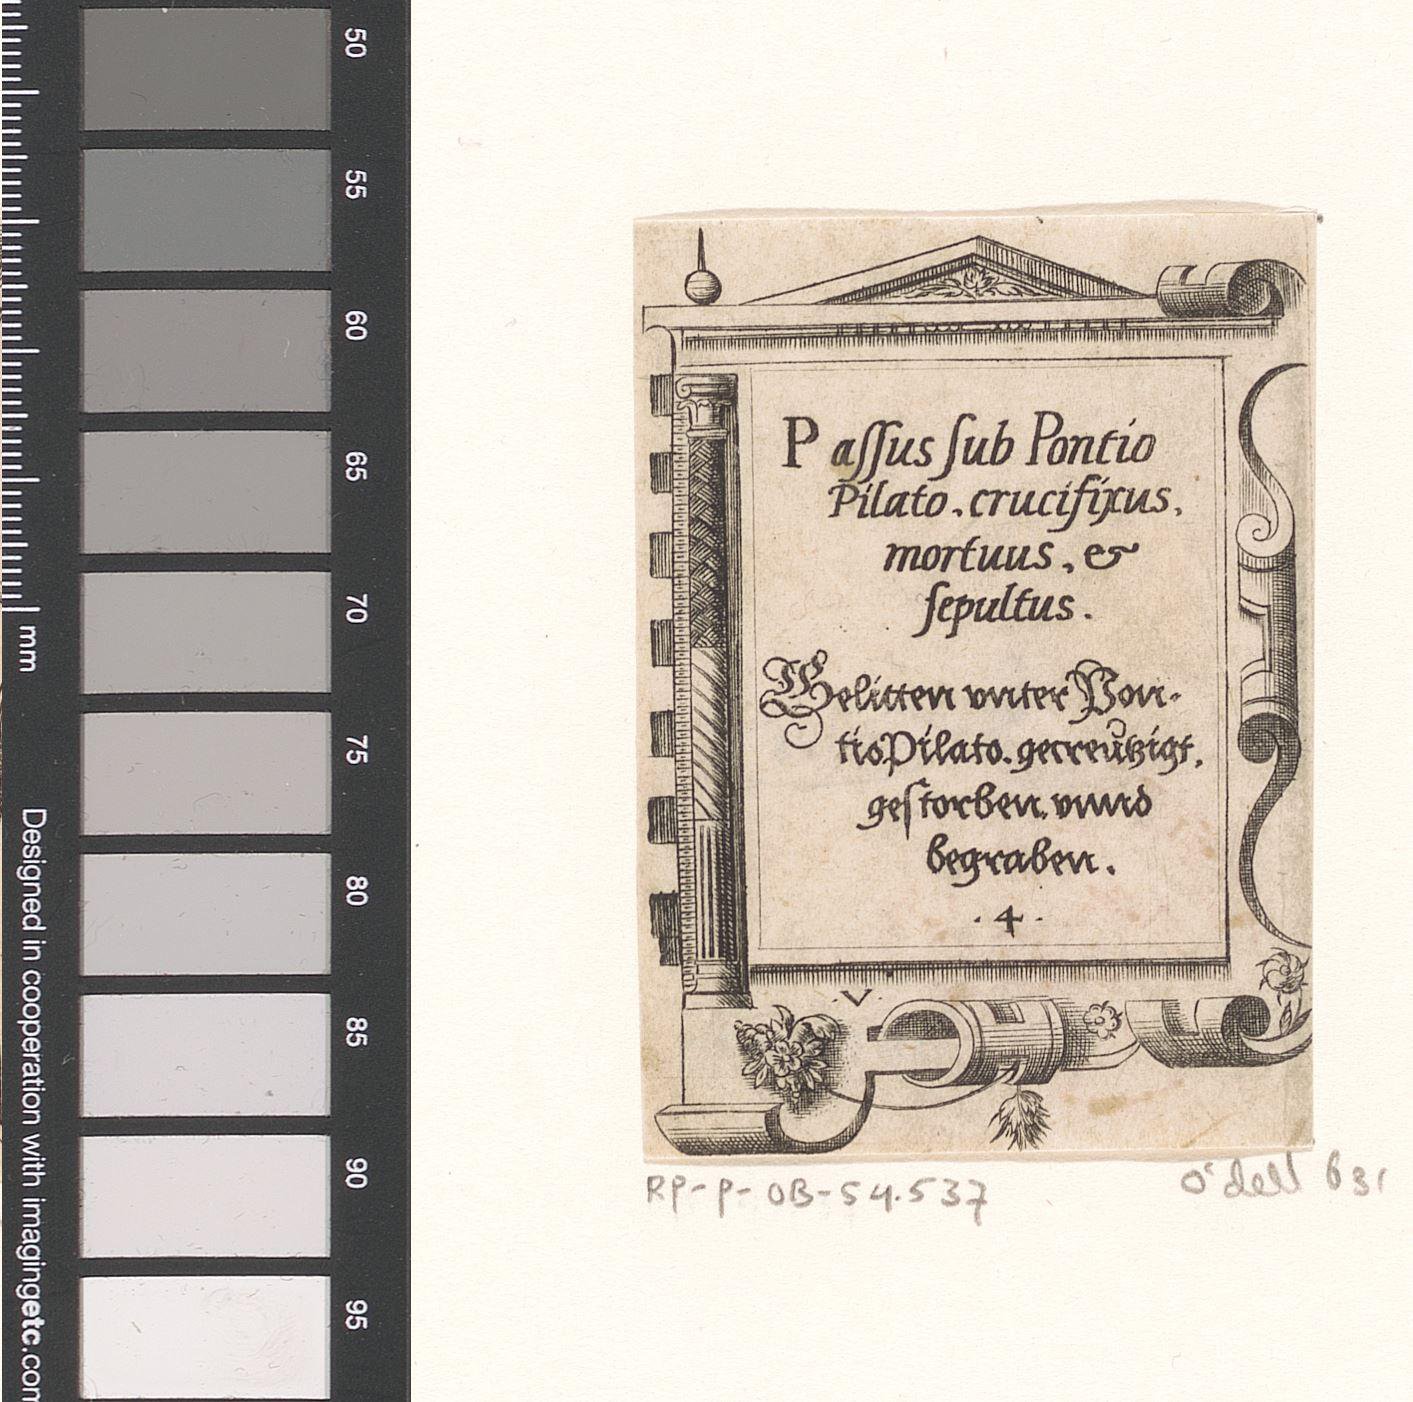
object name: print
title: Gebed in Latijn en Duits in een rolwerk omlijsting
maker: virgilius solis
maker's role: draughtsman, print maker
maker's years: 1514-1562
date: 1568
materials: paper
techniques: engraving, etching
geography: nuremberg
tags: scrollwork, strapwork ~ ornament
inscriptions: number: ‘87’, collector's mark: Lugt 240, collector's mark: Lugt 2228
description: Prent gebruikt voor het gebedenboek: Solis, Virgil. Ein New Künstlich Betbüchlein. Neurenberg: Hieronymus Petri, 1568. Bij elke prent met afbeelding van een apostel behoort een prent met een gebed in het Latijn en in het Duits. Bij elkaar horende prenten hebben dezelfde nummering en het monogram VS is steeds verspreid over twee bladen met dezelfde nummering.